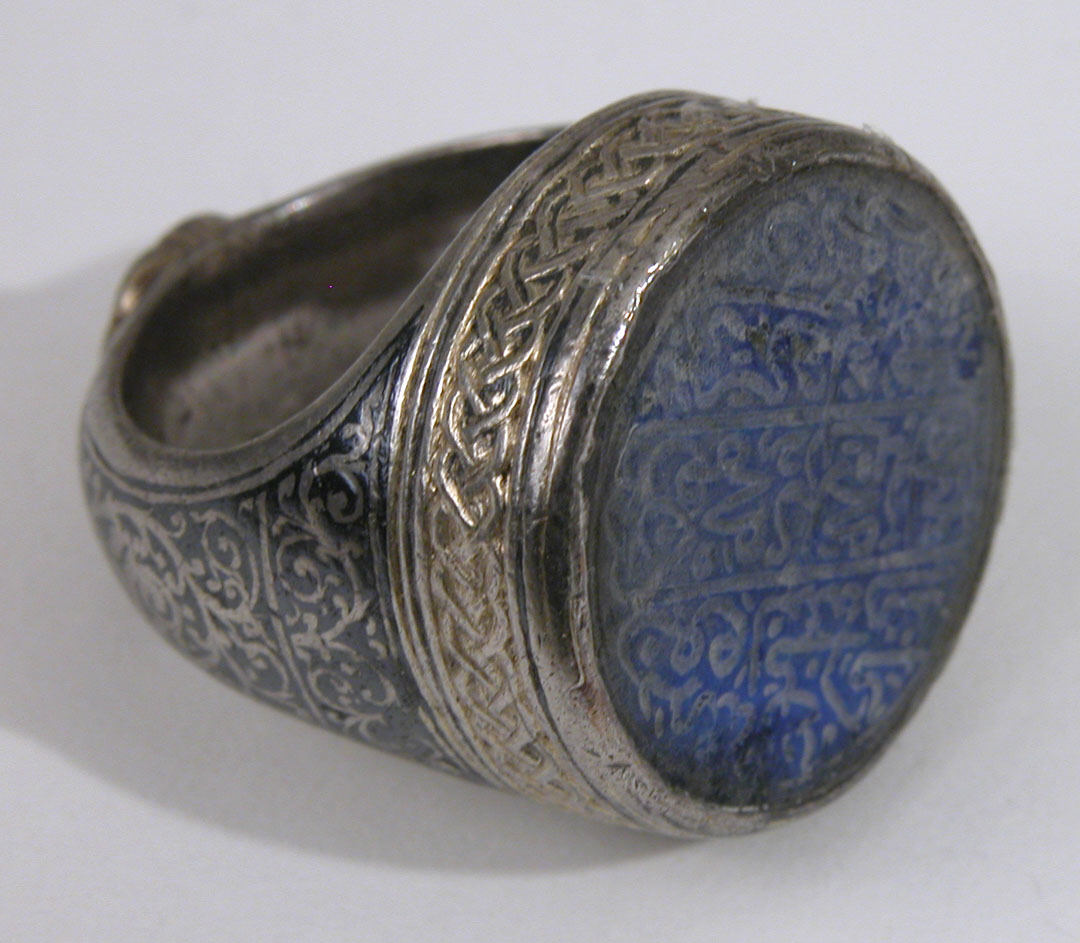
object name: ring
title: Seal Ring with the Name of Hajji Muhammad ibn Mahmud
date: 1501-1600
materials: lapis lazuli, silver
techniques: carving, gilding, inlay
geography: central asia